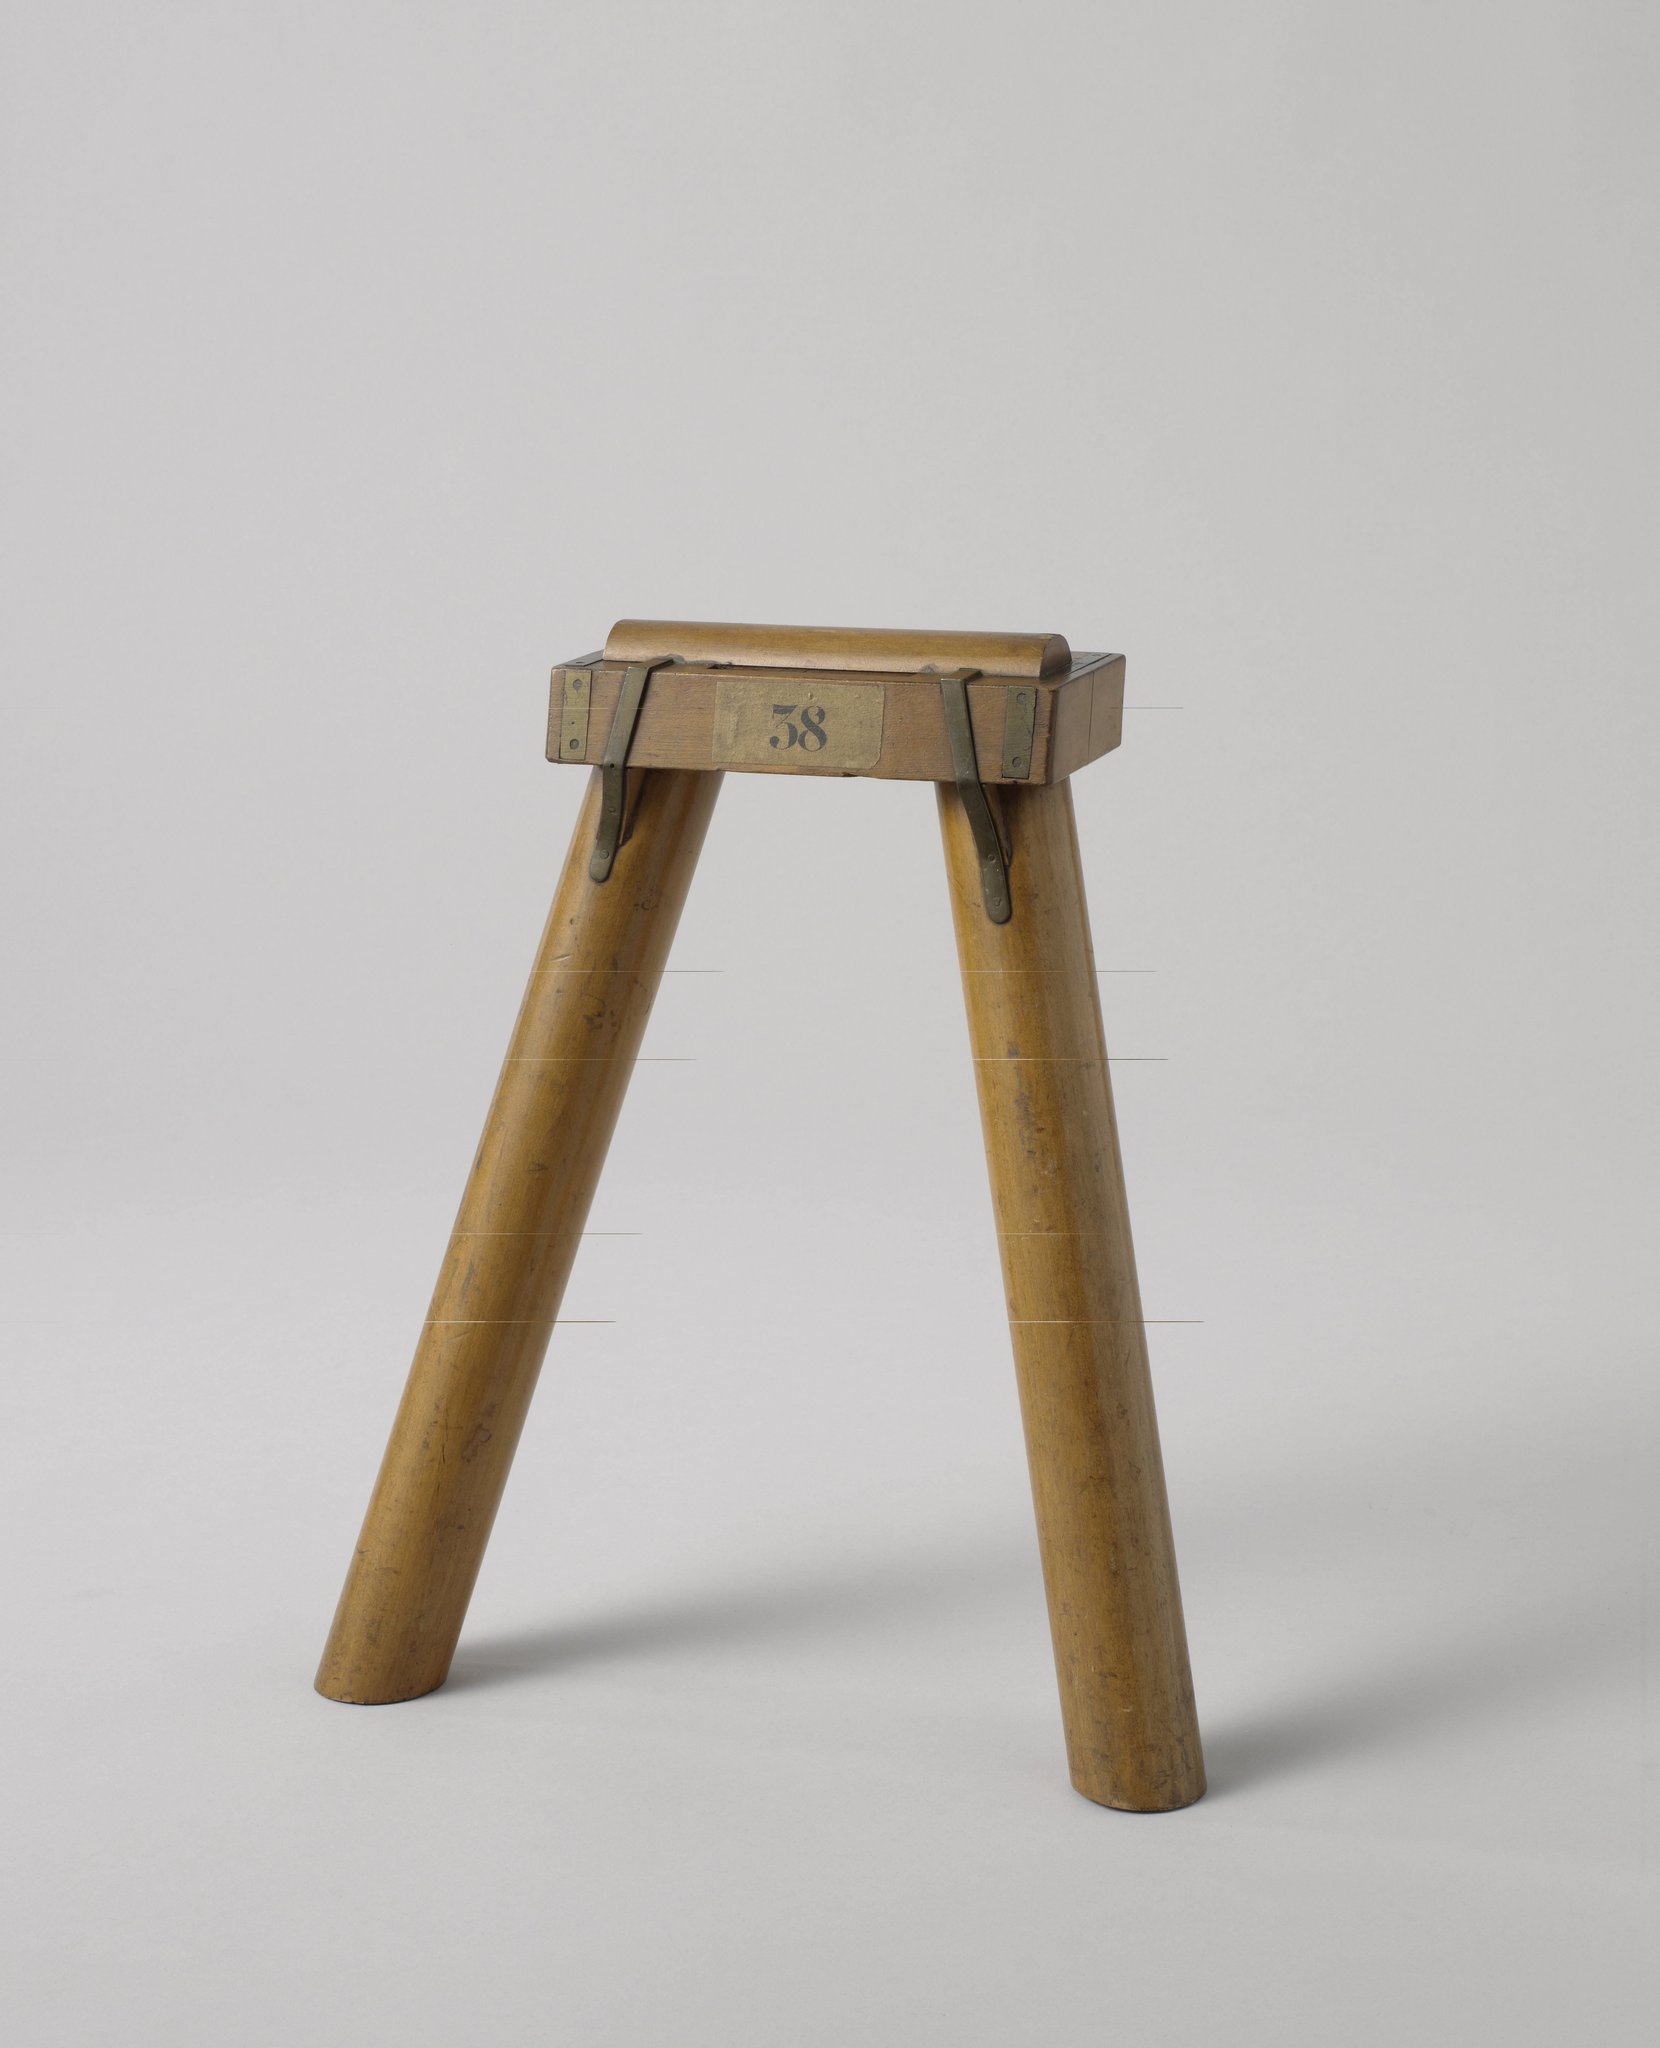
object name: demonstration model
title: Model of the Head of the Masting Sheers at Hellevoetsluis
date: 1818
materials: brass, wood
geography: rotterdam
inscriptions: label, top: ‘38’ former inventory label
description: Model van het bovenste gedeelte van de poten van een mastkraan, verbonden door een samengestelde dwarsbalk, waarin sleuven voor de gording en blokken. Het model is een detail van de mastkraan van Hellevoetsluis, zoals beschreven onder NG-MC-37.